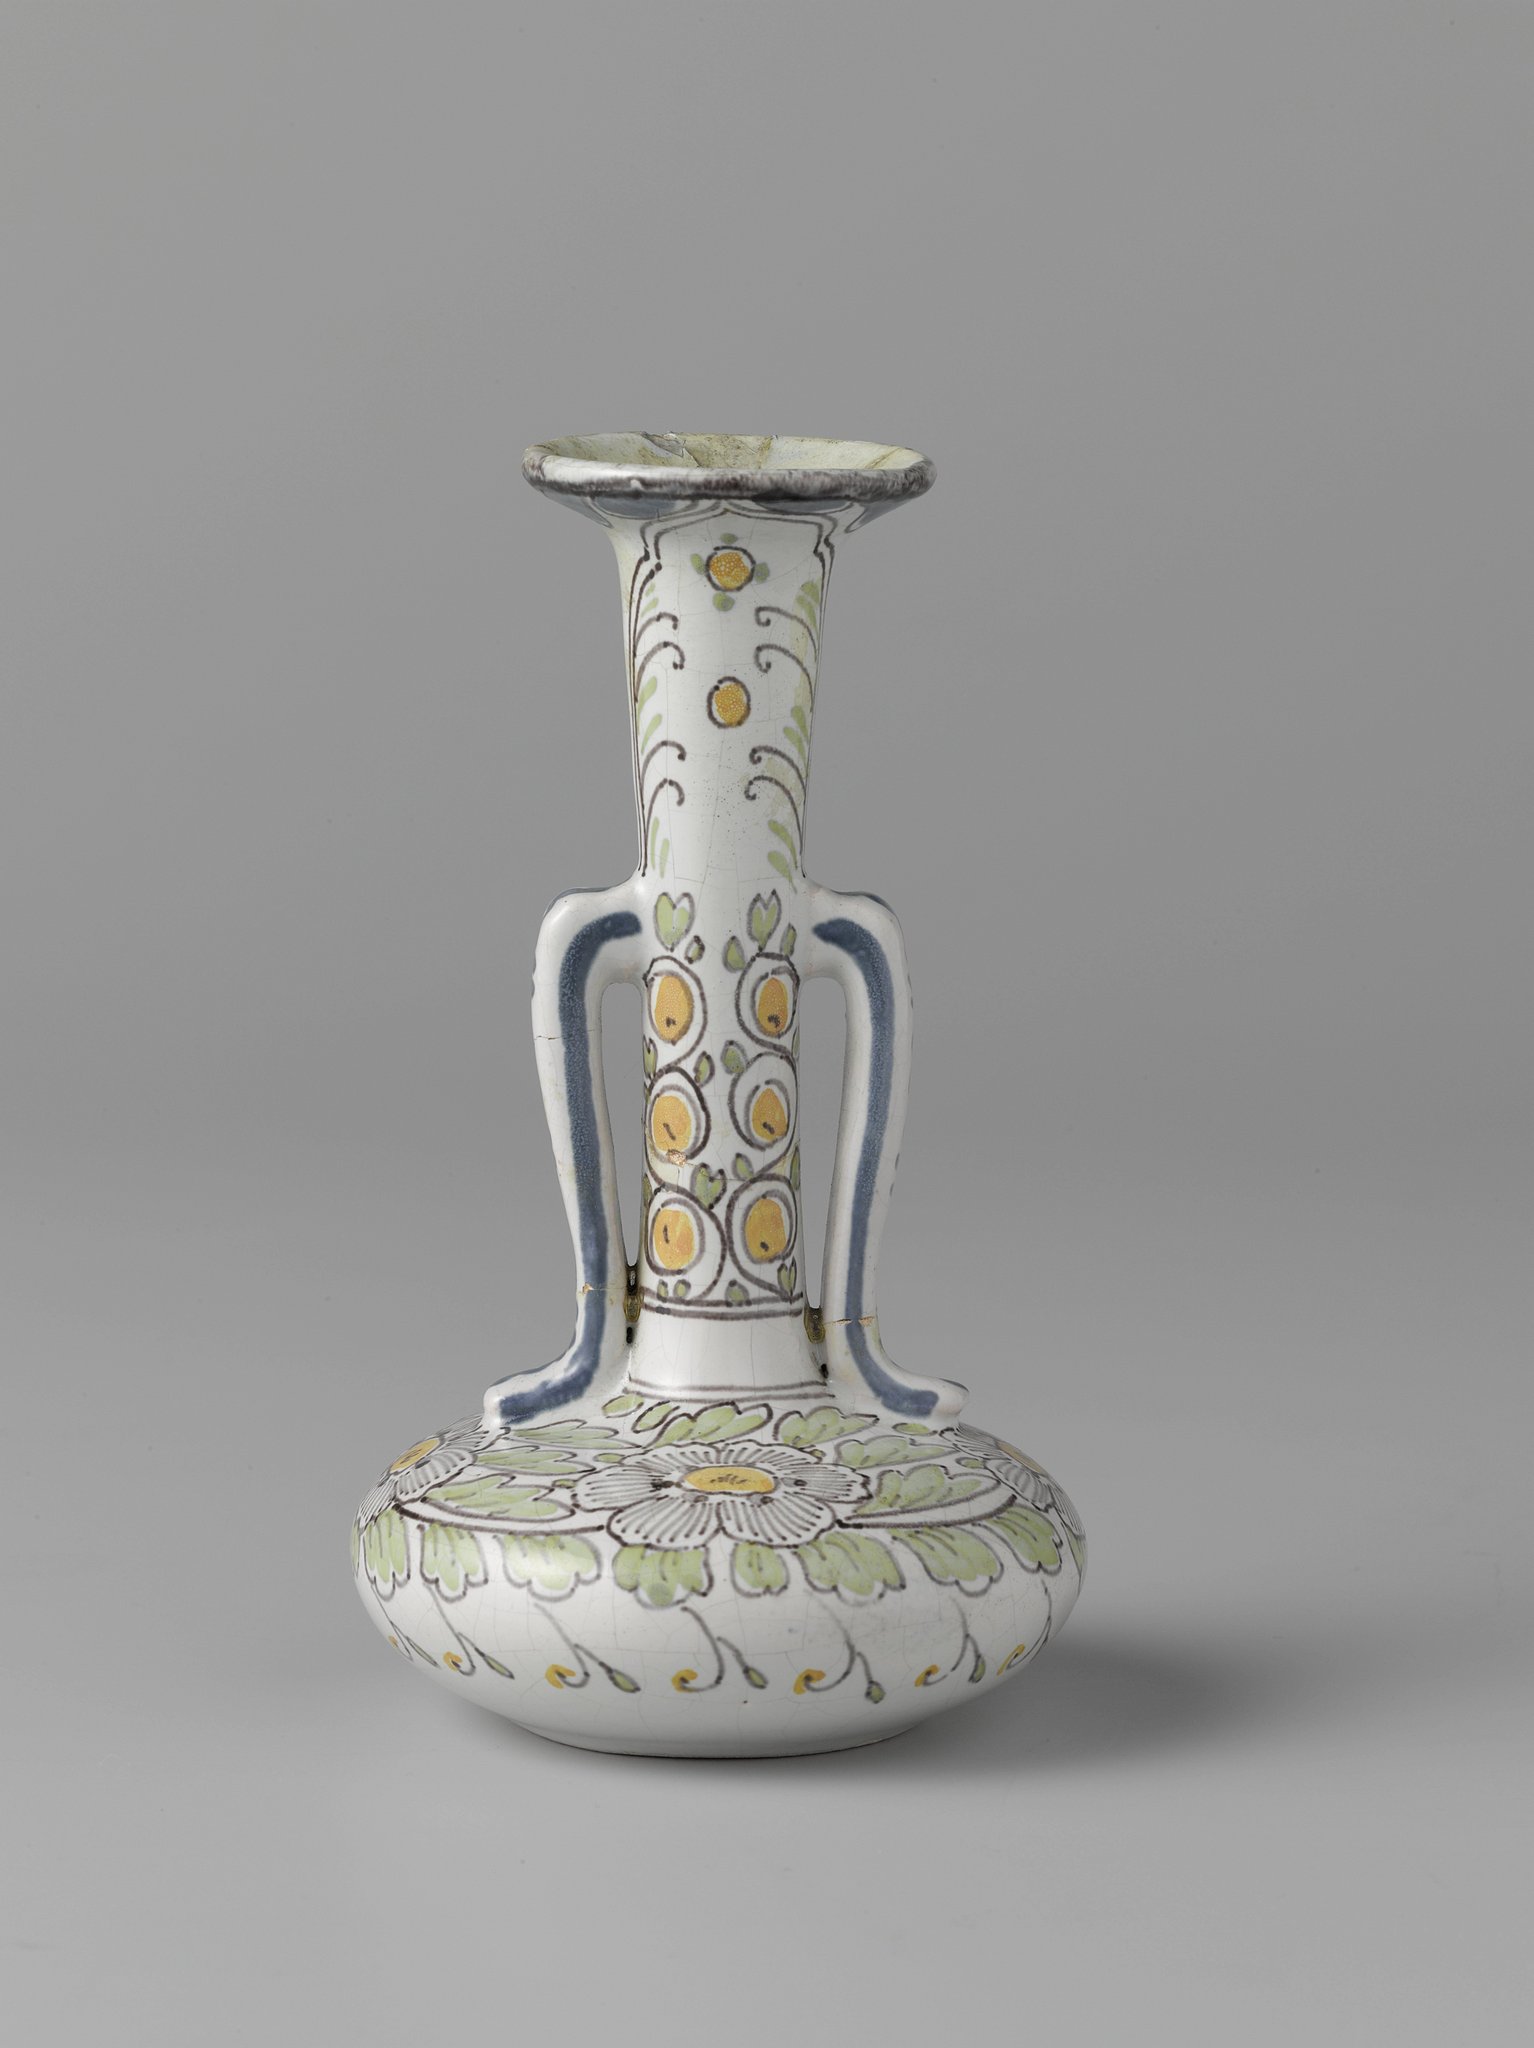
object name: vase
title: Vaas met lange hals en twee gerekt S-vormige oren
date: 1880-1920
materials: earthenware, glaze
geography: delft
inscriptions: mark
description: Vaas van aardewerk, met bol lichaam en lange smalle hals met uitstaande mondrand. Langs de hals twee gerekt S-vormige oren. Beschilderd in blauw, groen, geel en zwart met op het bolle lichaam vier bloemen omgeven door bladeren, op de hals oranjeappels.